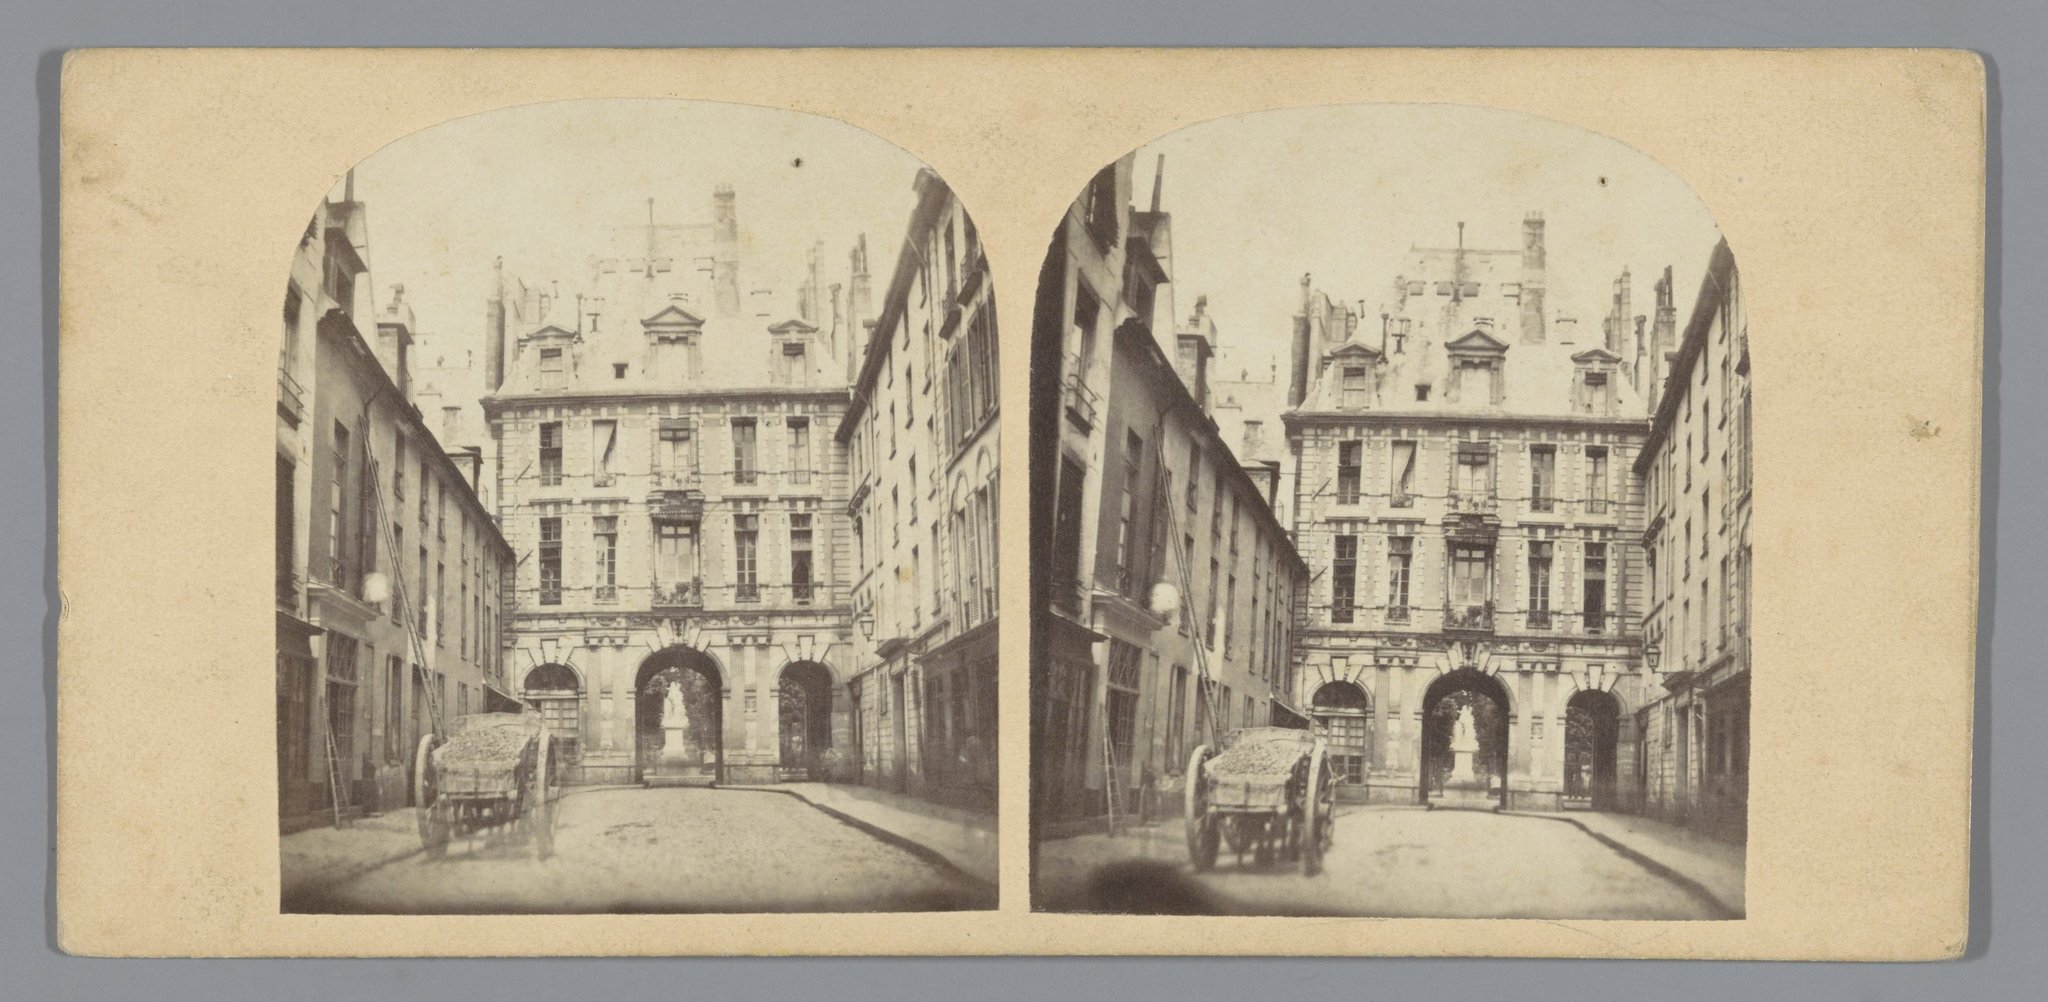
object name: stereograph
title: Palais Royal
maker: Anonymous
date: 1851-1880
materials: cardboard, paper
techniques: albumen print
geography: palais-royal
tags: inner court of palace or 'hôtel'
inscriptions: number: ‘68’